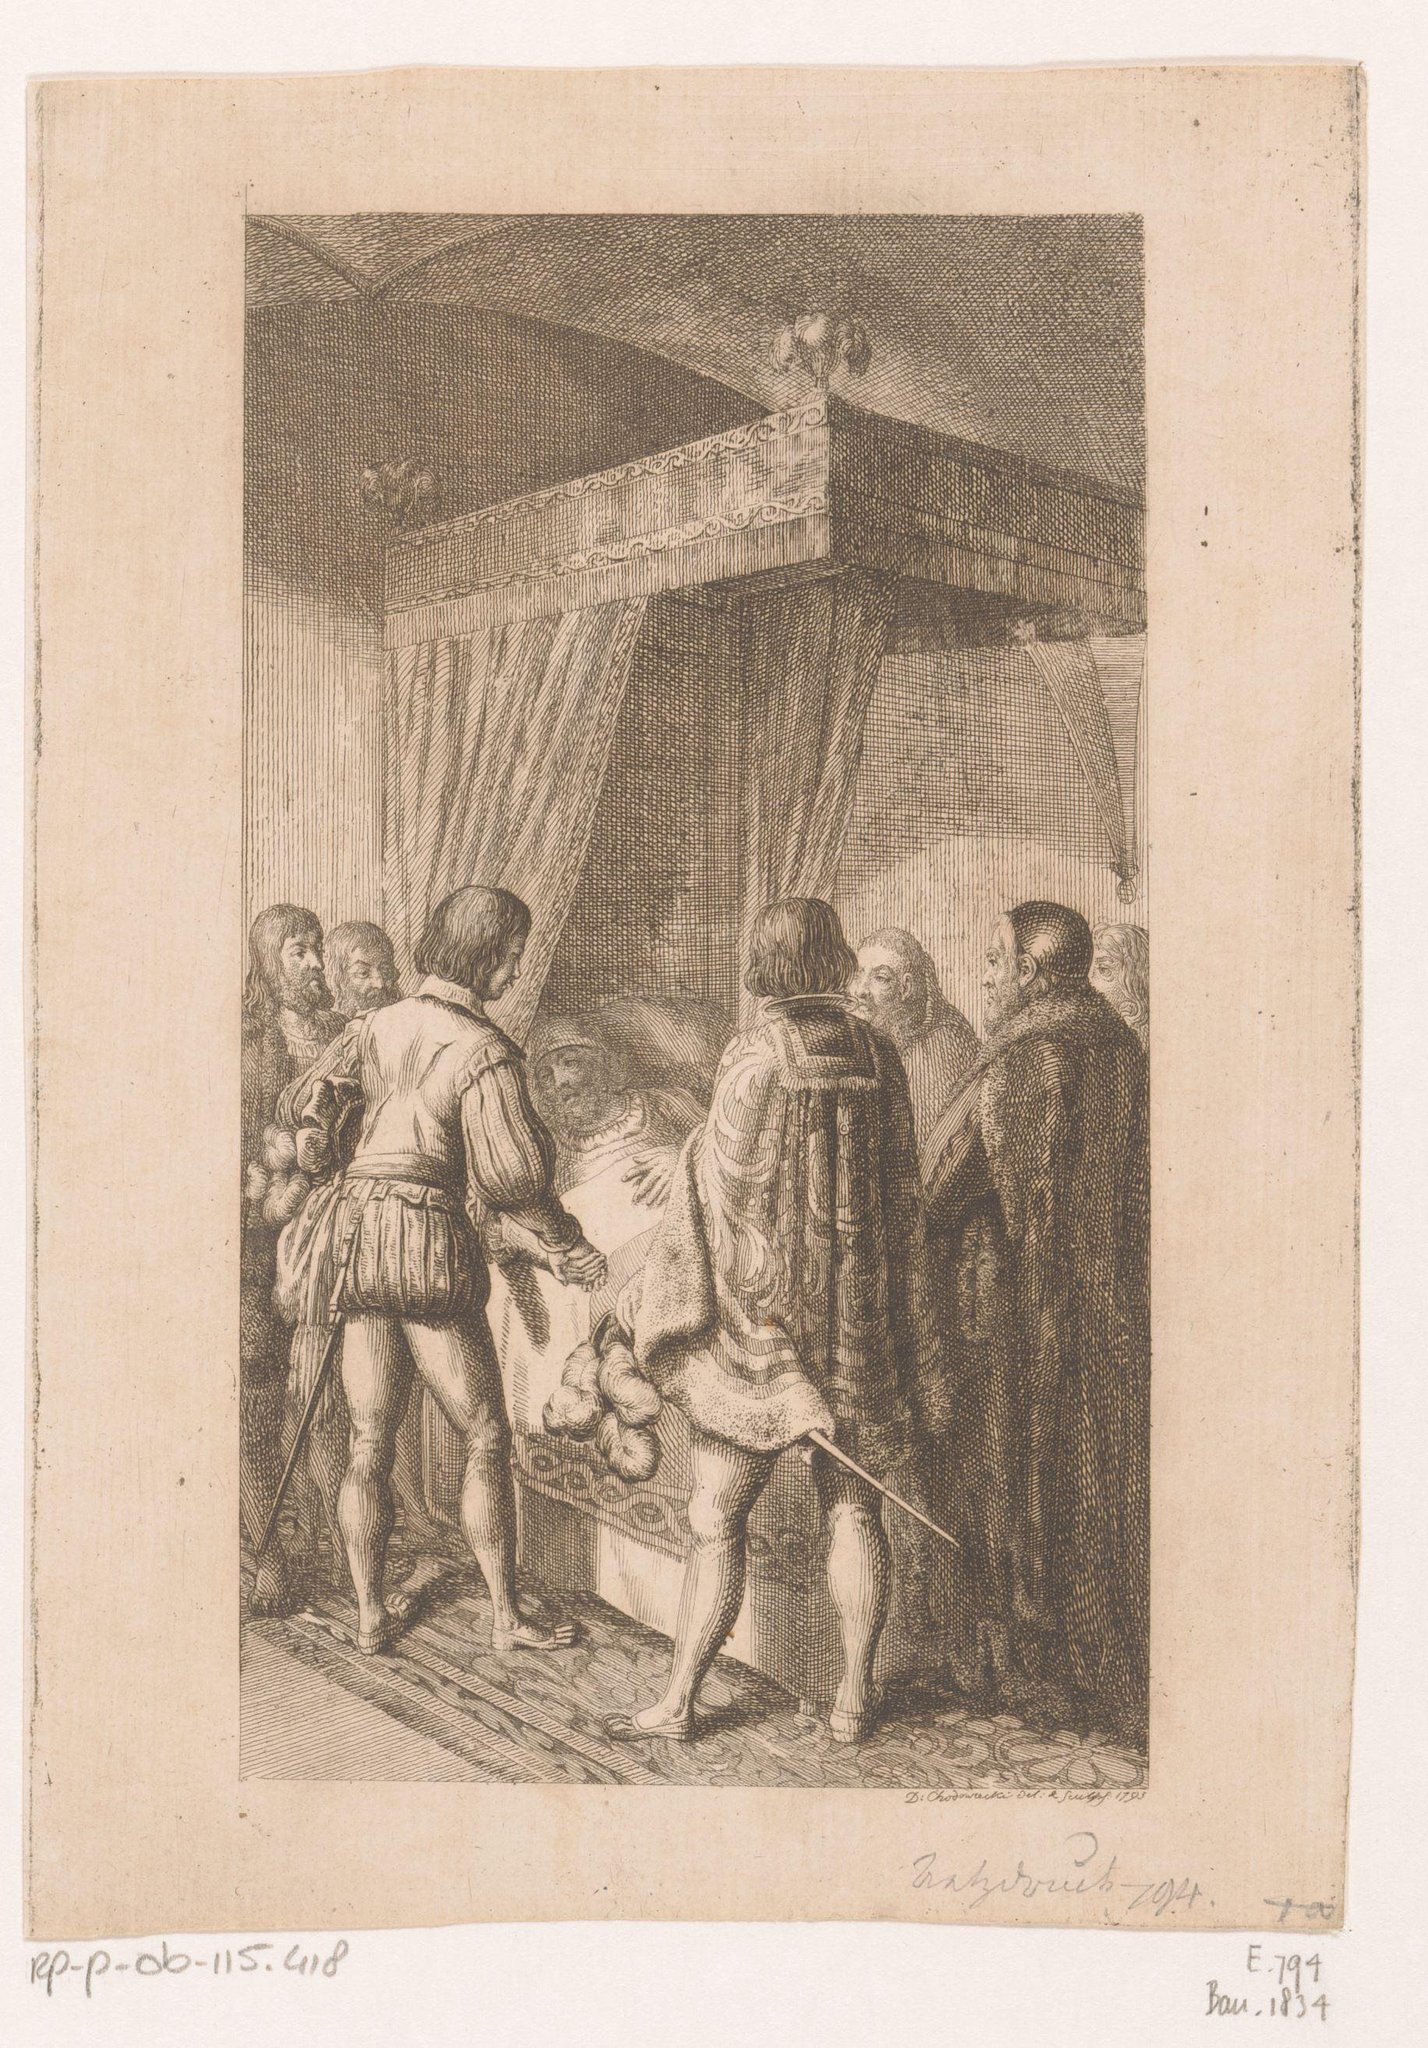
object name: print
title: Otto II van Beieren op zijn sterfbed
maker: daniel nikolaus chodowiecki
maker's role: draughtsman, print maker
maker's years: 1726-1801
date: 1795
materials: paper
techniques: etching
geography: berlin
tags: history, deathbed, ruler, sovereign, father and son(s) (family group)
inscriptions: collector's mark: Lugt 2228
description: Prent gebruikt voor: Deutsche Monatsschrift (...). 3 dln. Leipzig: Sommersche Buchhandlung, 1795.